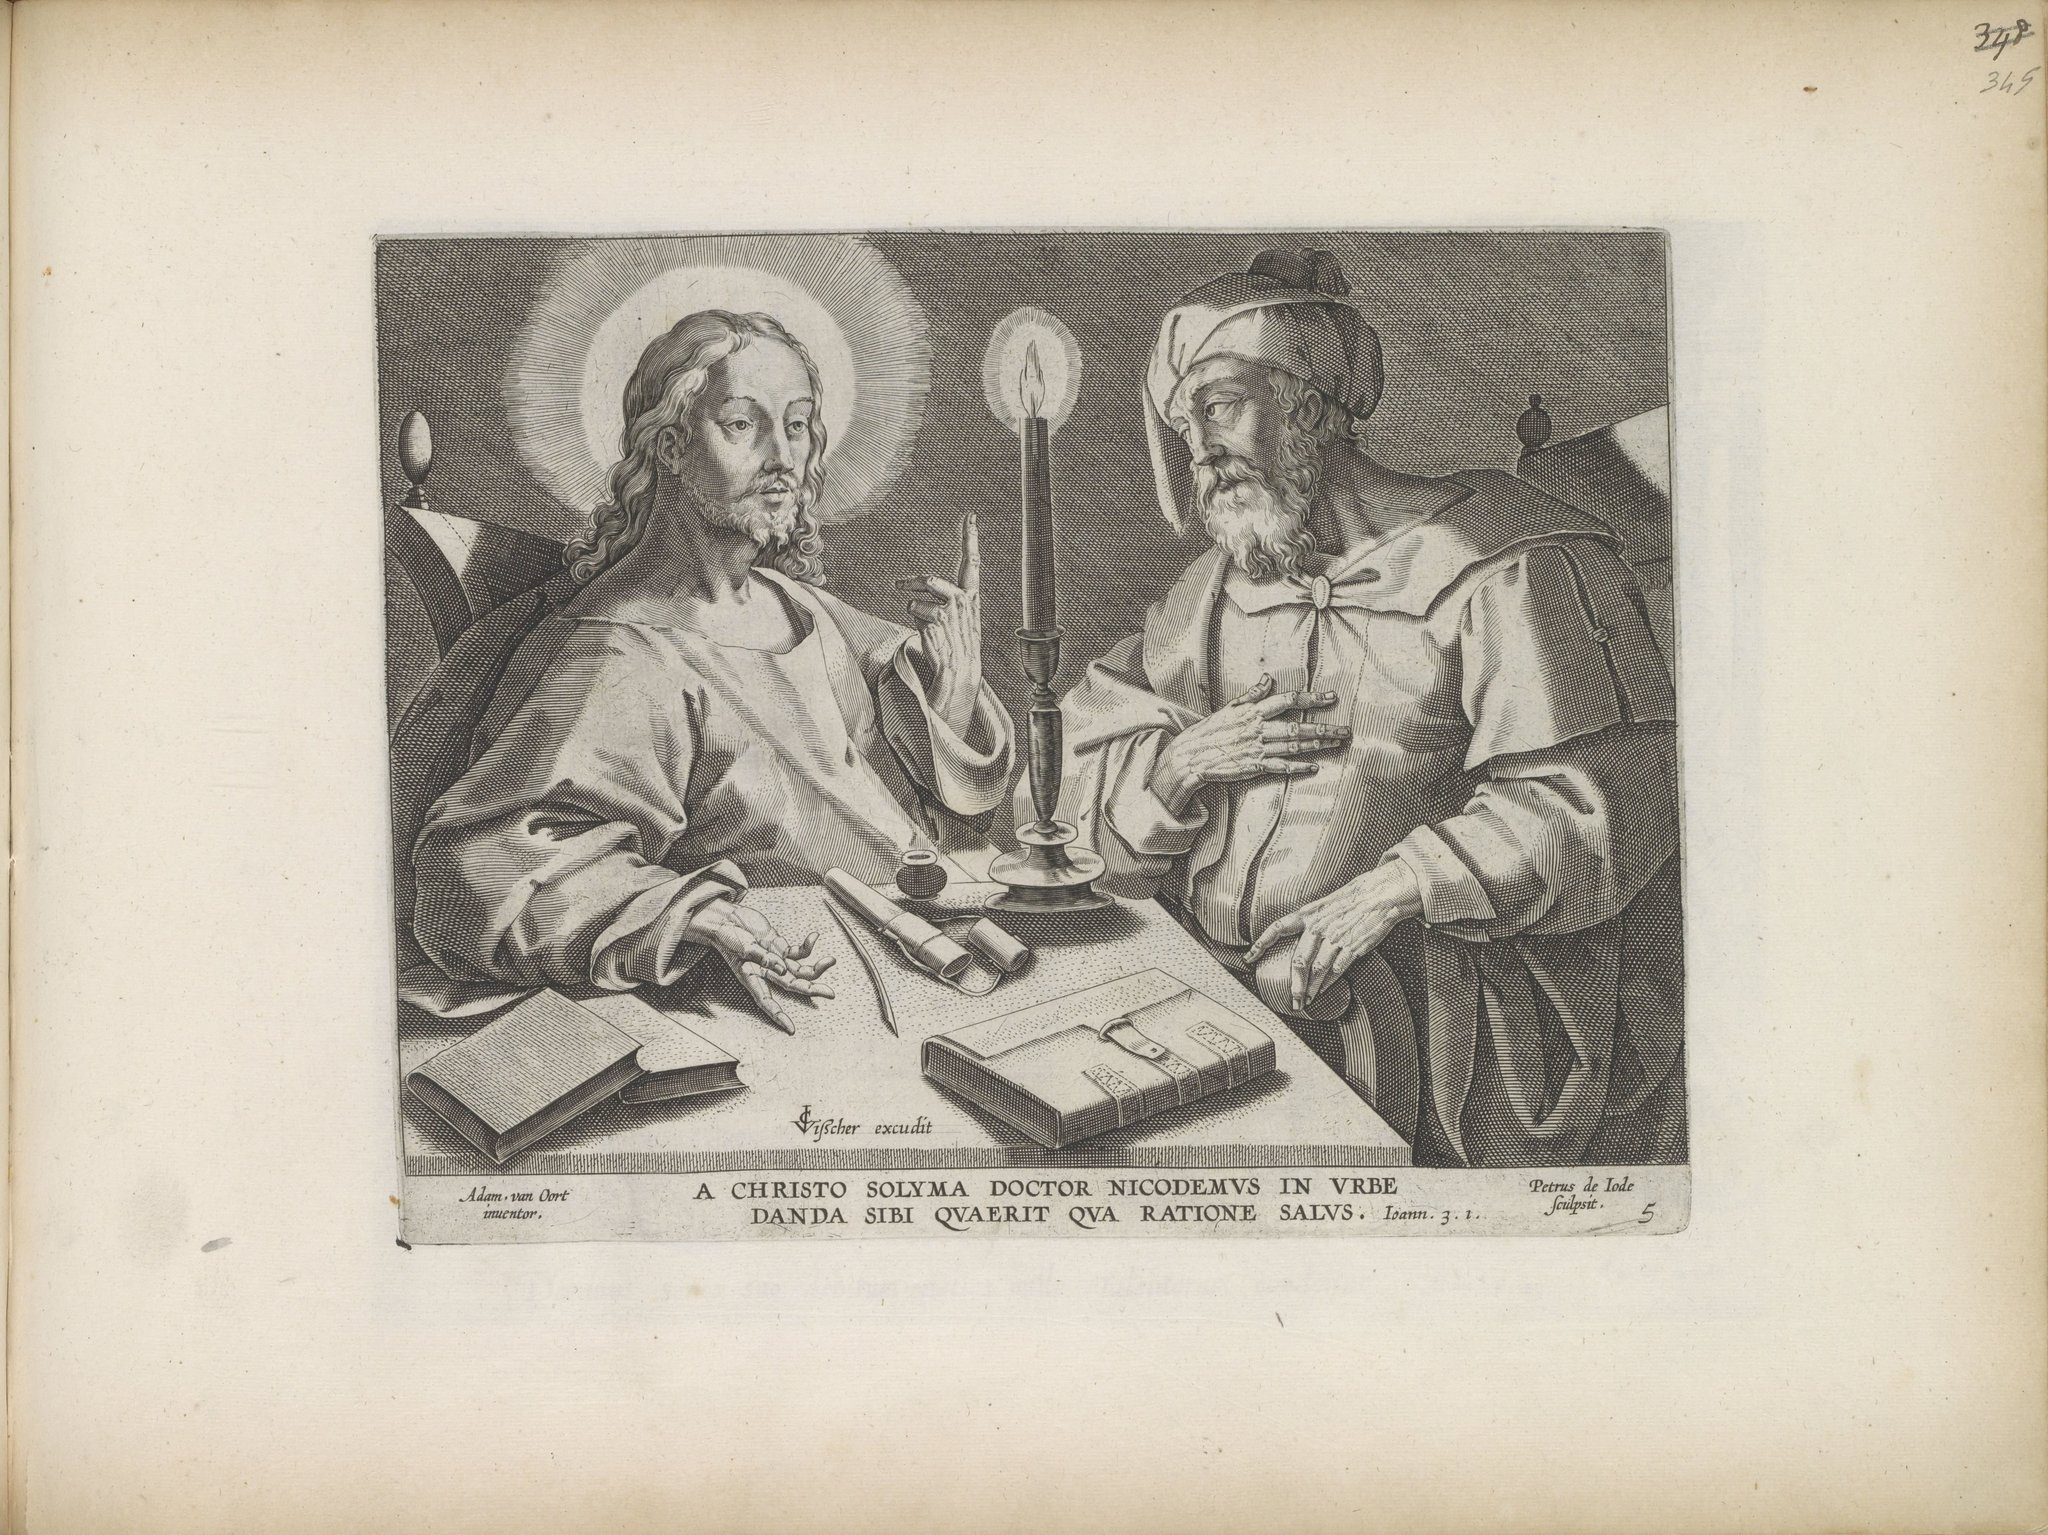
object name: print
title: Gebeurtenissen uit het leven van Christus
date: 1585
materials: paper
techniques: engraving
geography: amsterdam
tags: christ talking with nicodemus at night (john 3:1-21)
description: De farizeeër Nikodemus komt in de nacht naar Christus. Christus spreekt met hem bij kaarslicht. Op tafel liggen boeken en schrijfgerei. Onder de voorstelling een verklarende tekst in het Latijn en een verwijzing naar de Bijbeltekst in Joh.3:1. Deze prent maakt deel uit van een album.